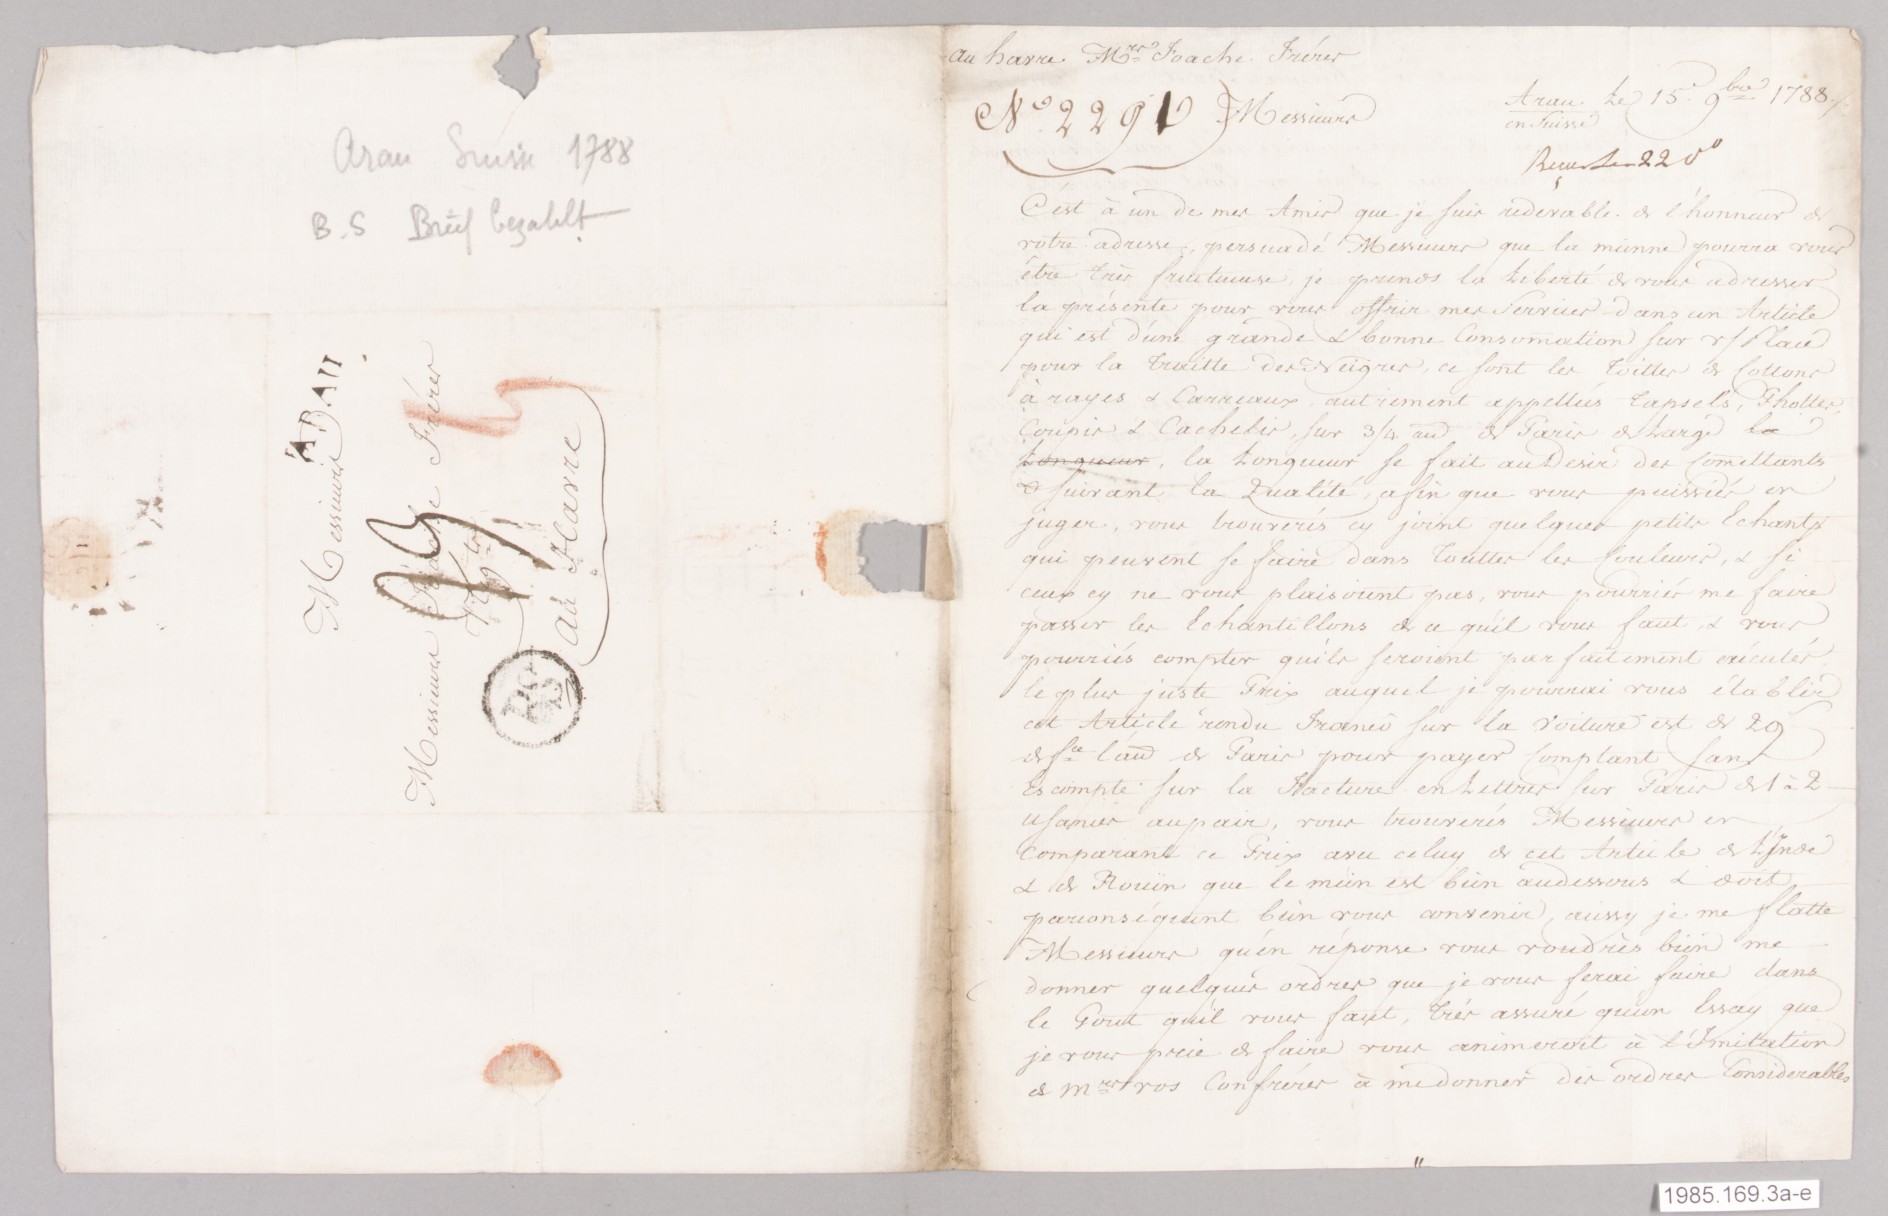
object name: letter with textile sample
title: Letter with textile samples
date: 1767-1833